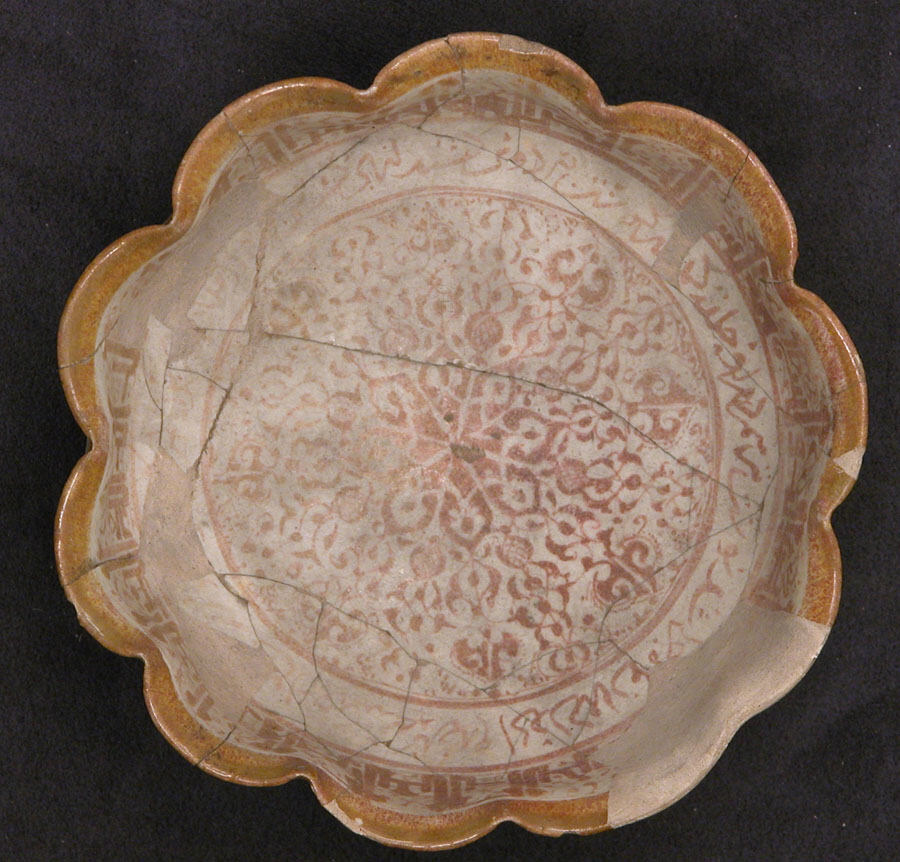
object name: dish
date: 1101-1300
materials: stonepaste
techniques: luster painting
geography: iran